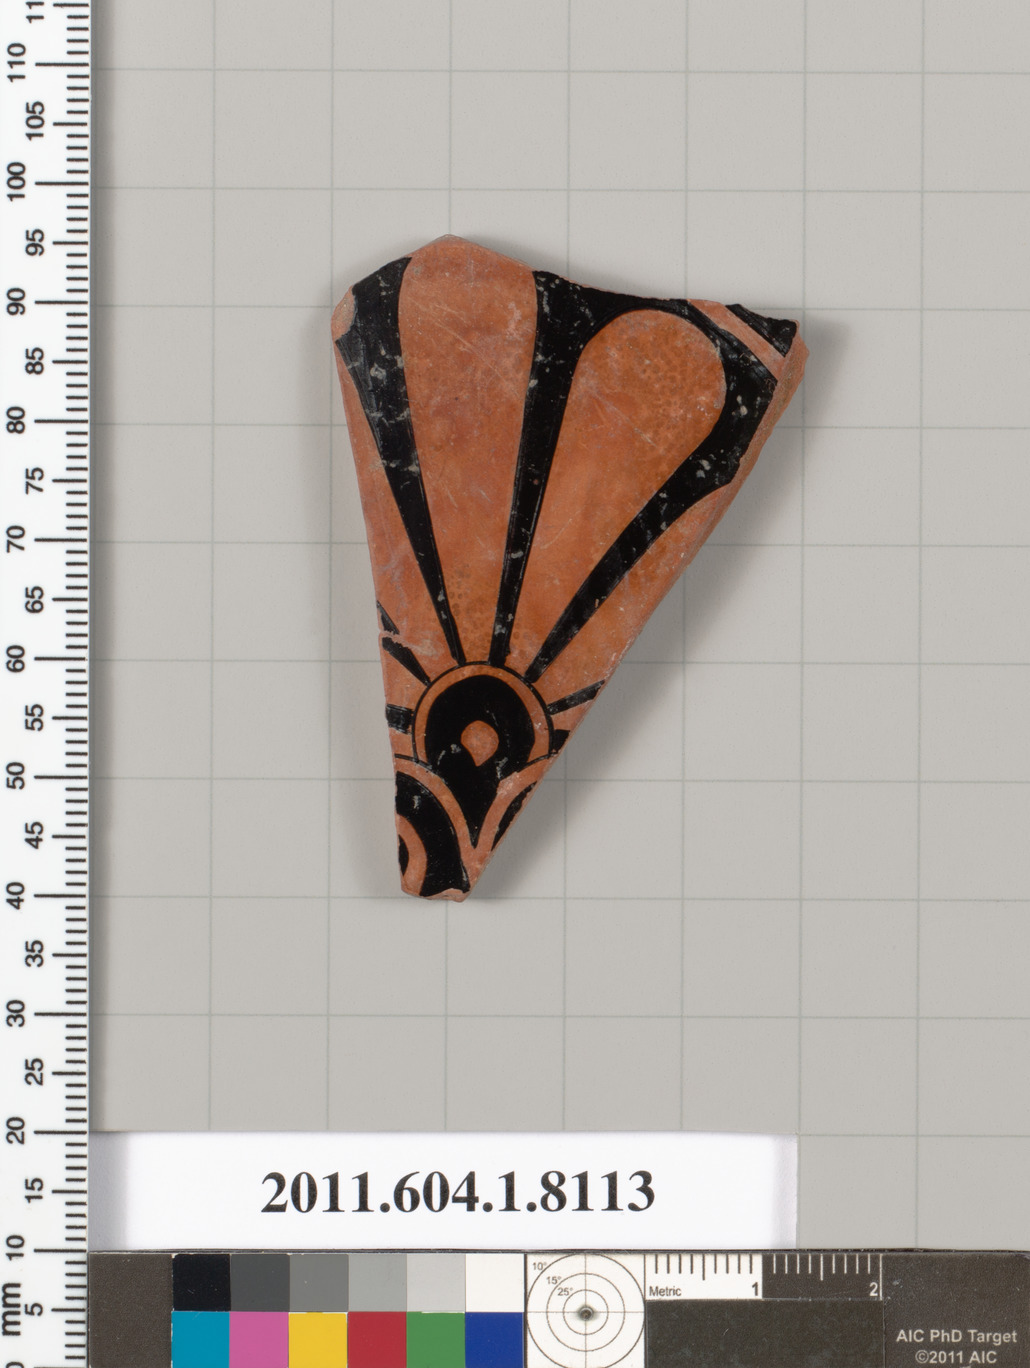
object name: kylix fragment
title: Terracotta fragment of a kylix (drinking cup)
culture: greek, attic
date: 534-468 BCE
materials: terracotta